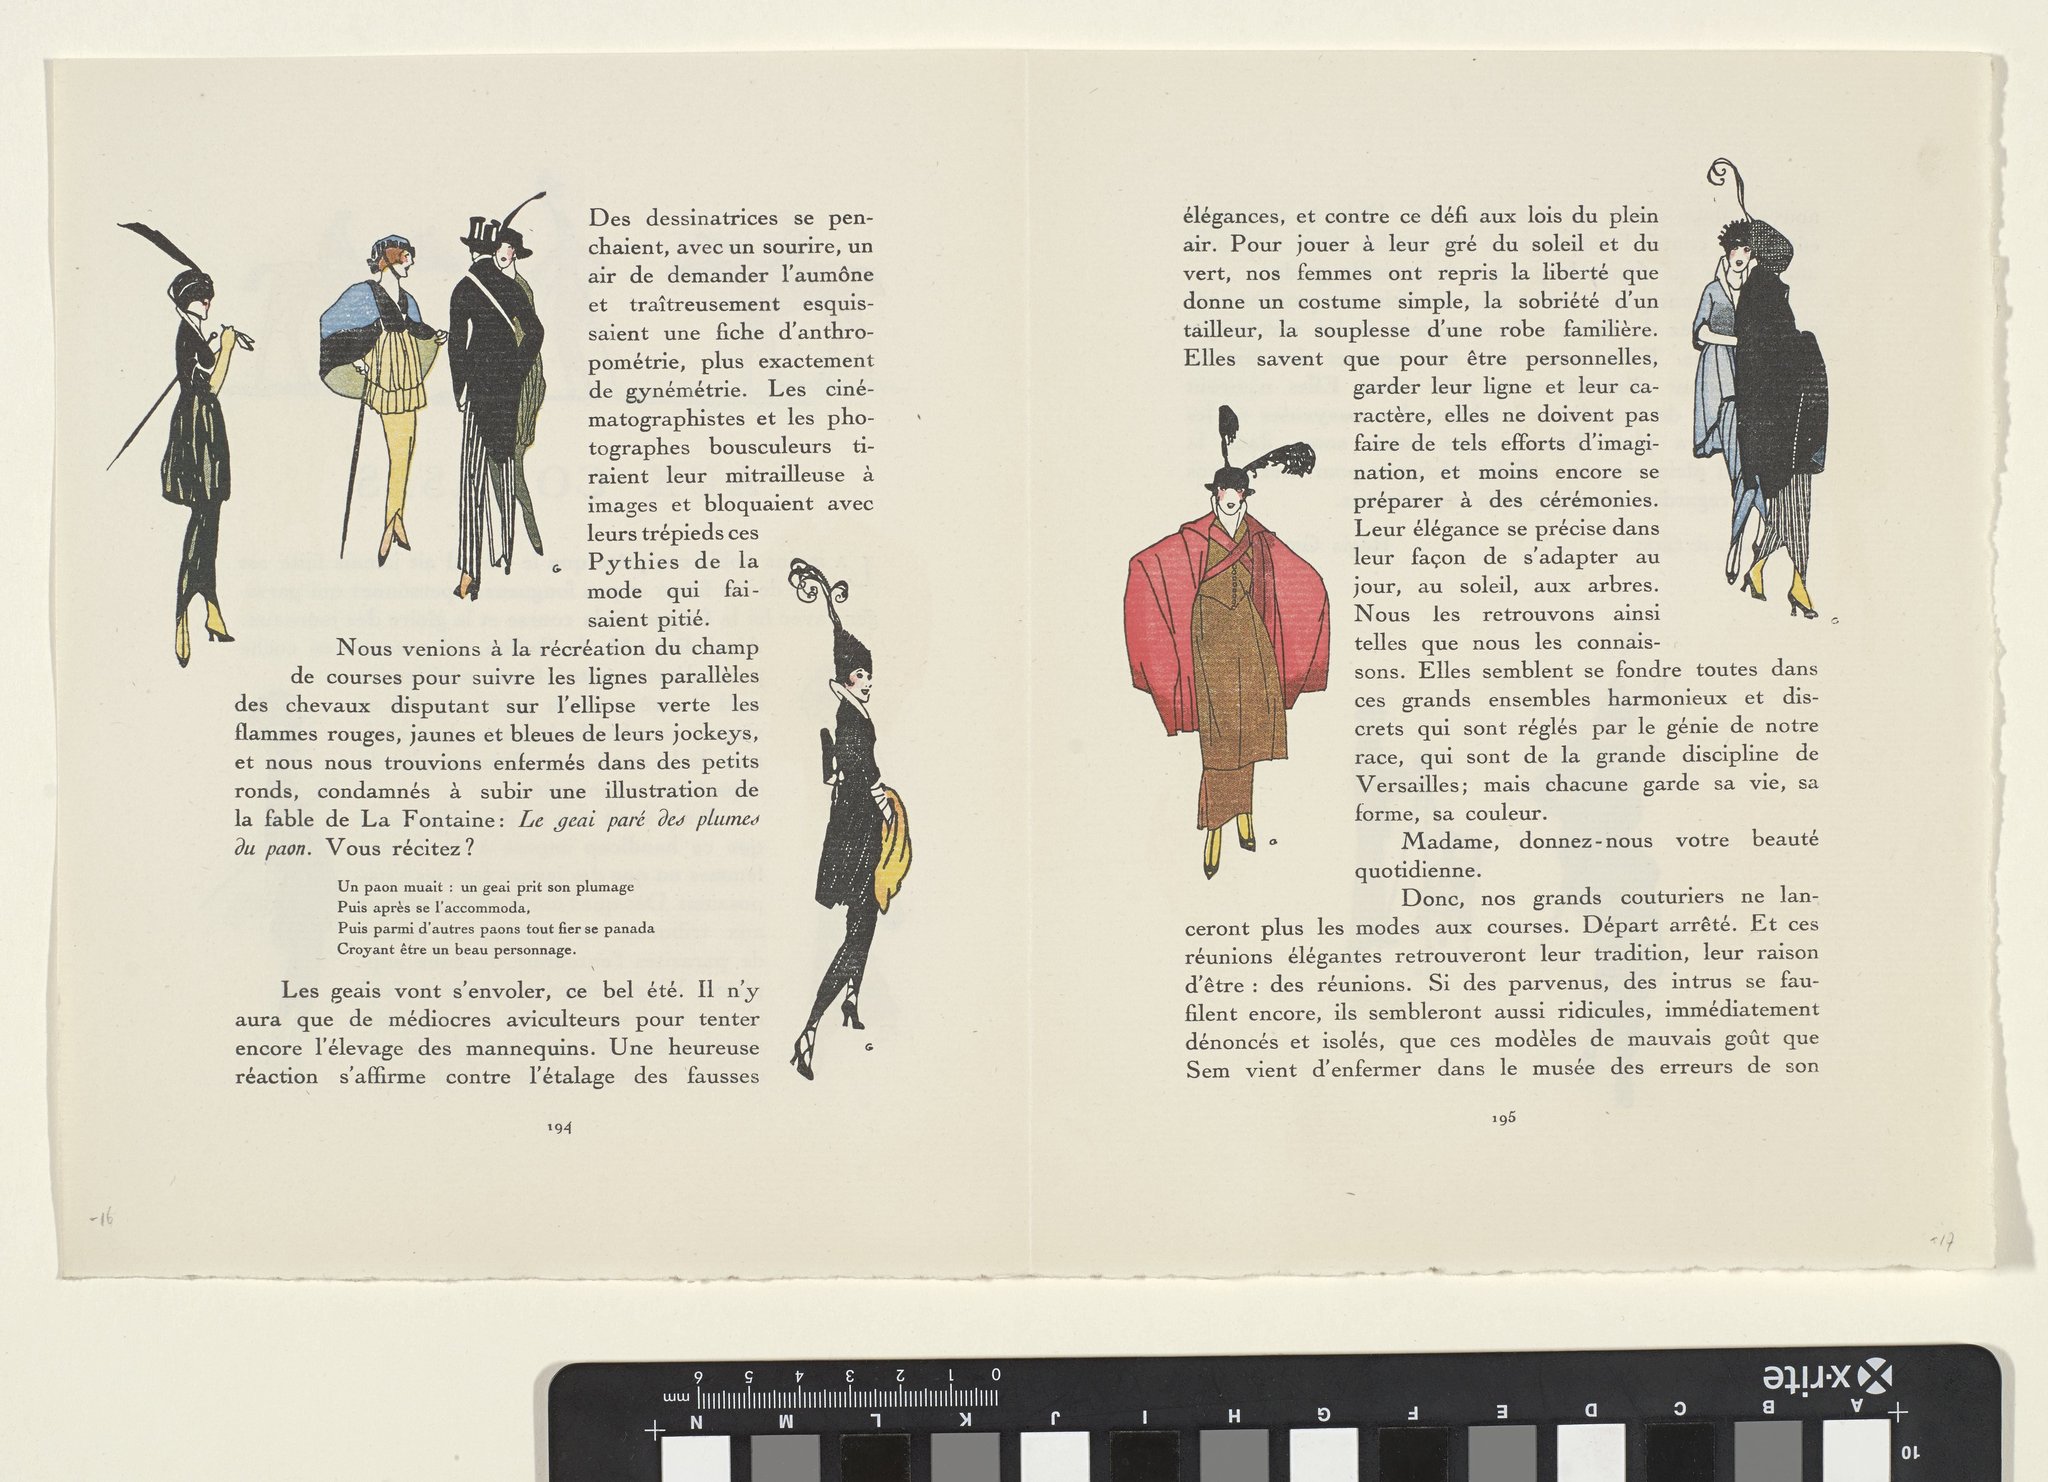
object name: fashion print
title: Gazette du Bon Ton, 1914 - No. 6, p. 195: Aux Courses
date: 1914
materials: paper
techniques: letterpress printing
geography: paris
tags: fashion plates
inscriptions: date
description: Aux Courses. Tekst en illustraties: vrouwen in modieuze ensembles voor de paardenrennen. Pagina 195 in Gazette du Bon Ton, 1914 - No. 6